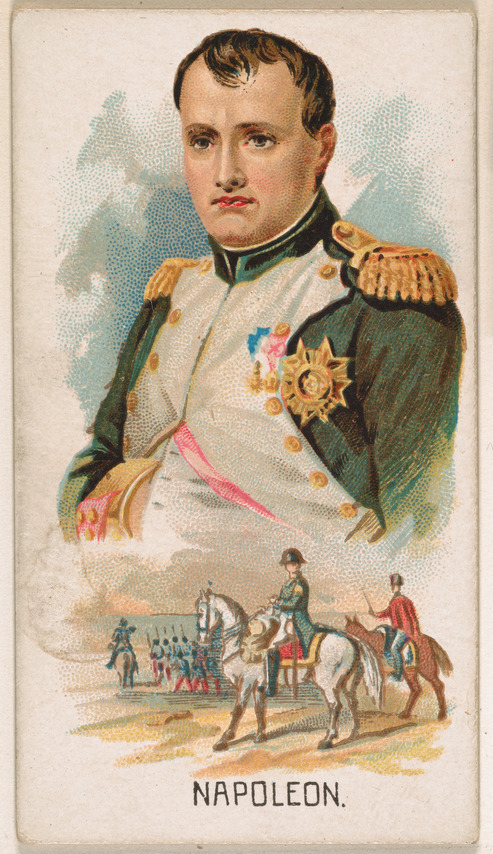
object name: print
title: Napoleon, from Leaders series (N222) issued by Kinney Bros.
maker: kinney brothers tobacco company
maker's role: publisher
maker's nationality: american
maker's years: 1869-2011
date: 1888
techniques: color lithograph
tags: napoleon i,men